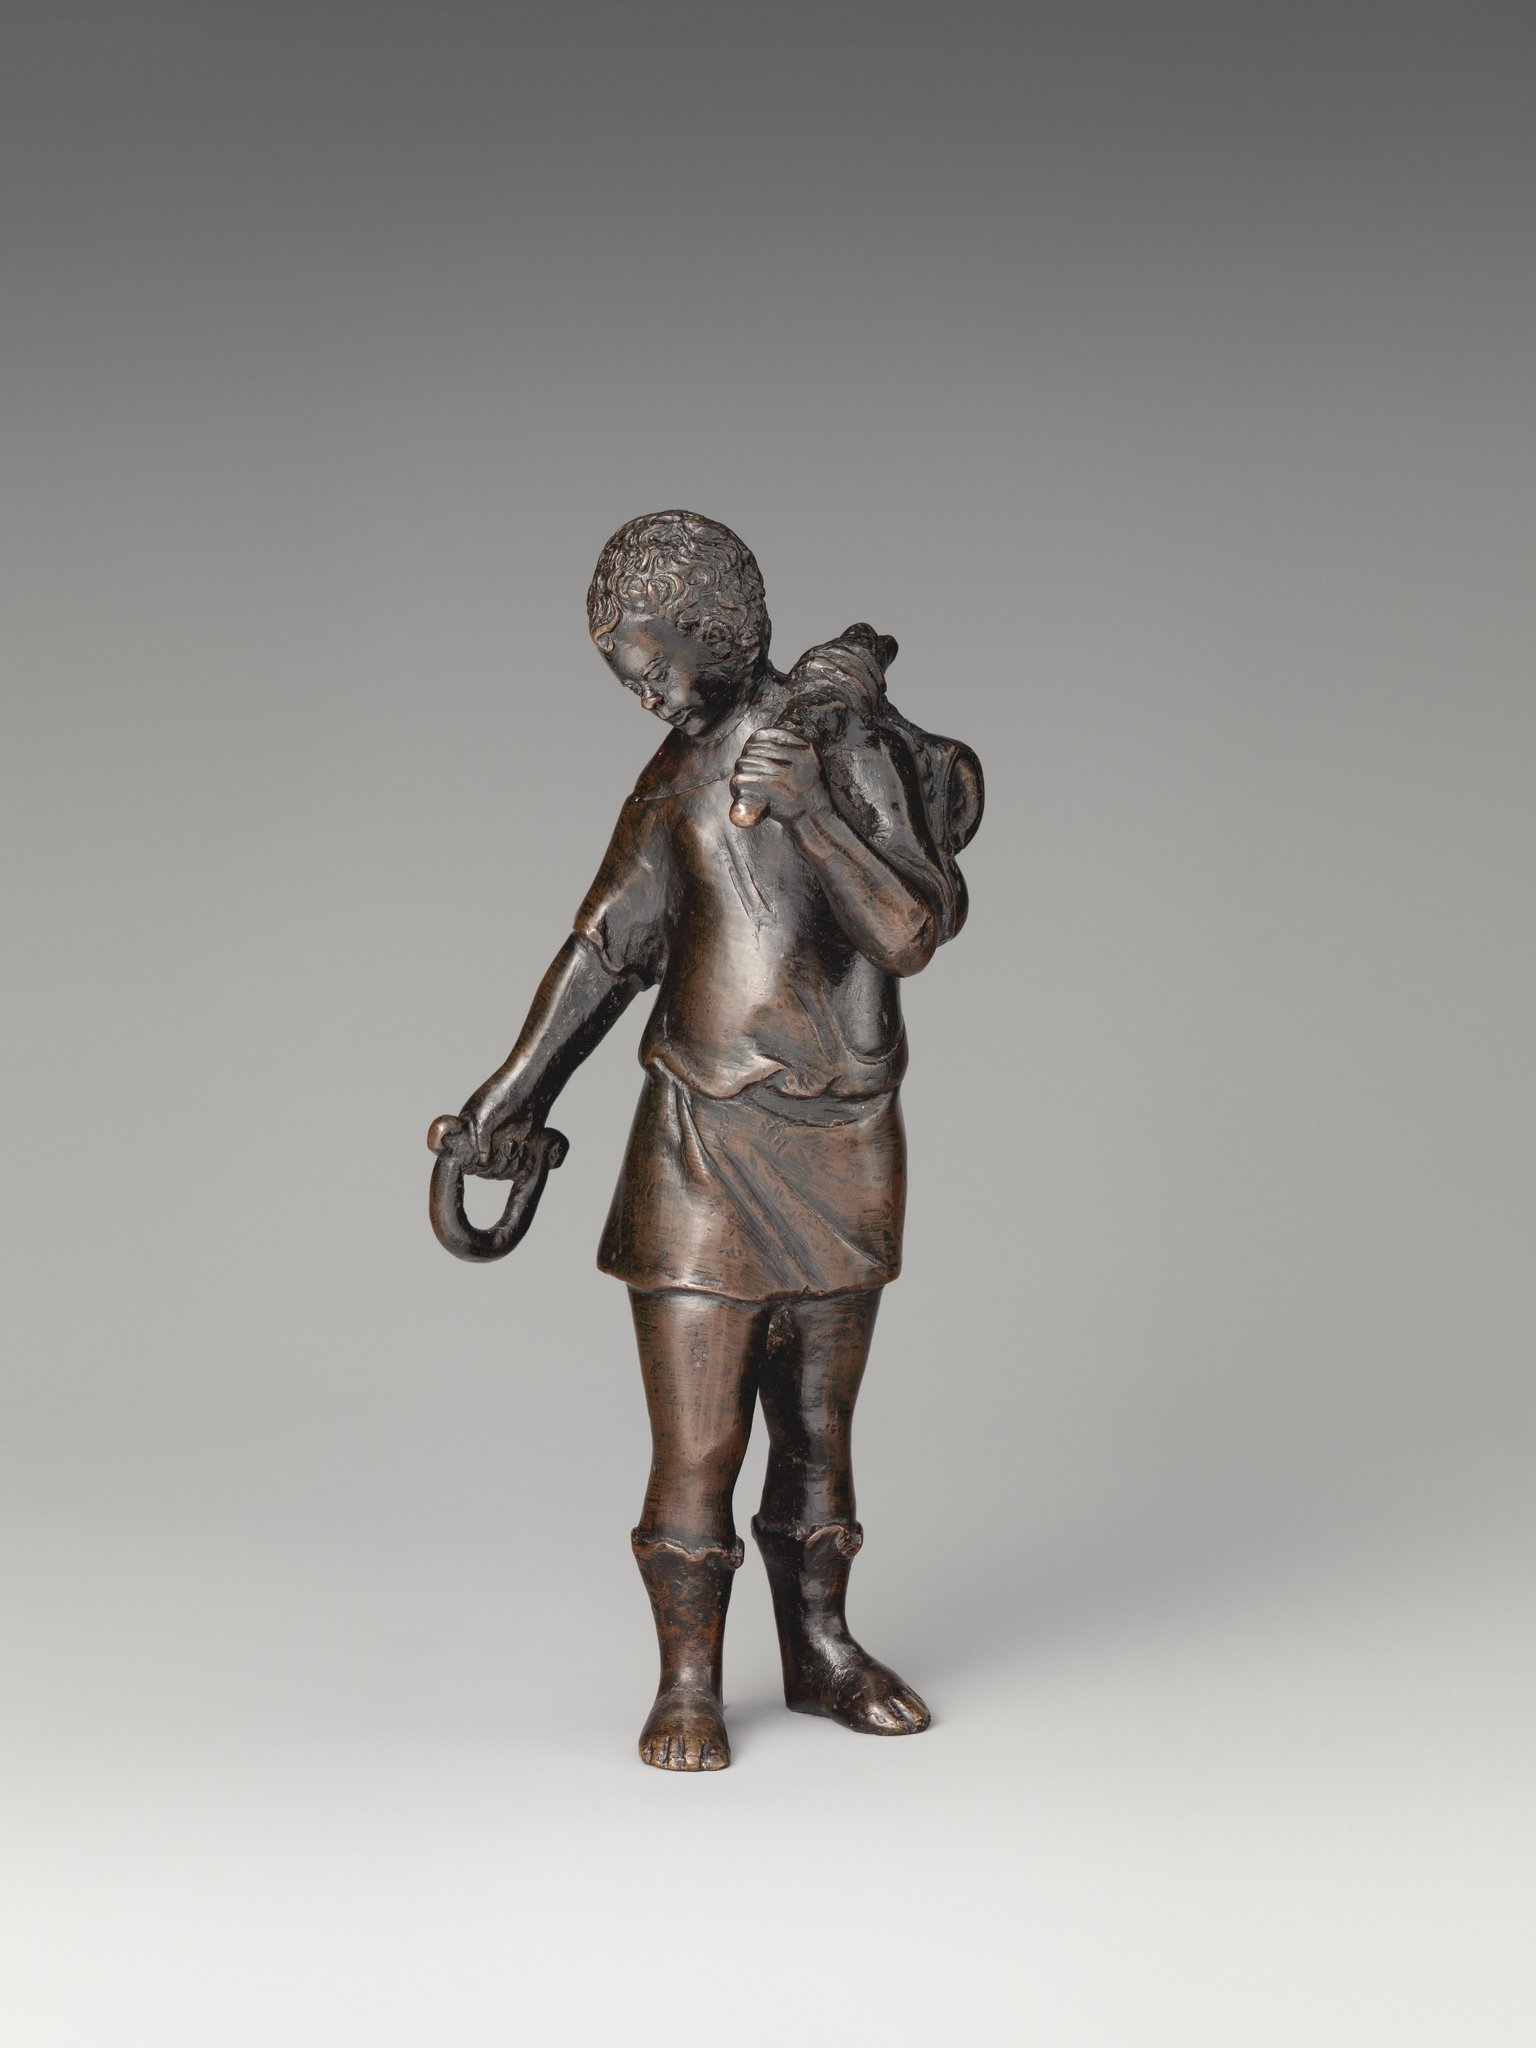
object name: statuette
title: Tobias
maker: severo calzetta da ravenna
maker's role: artist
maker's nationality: italian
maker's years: 1496-1543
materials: bronze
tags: boys